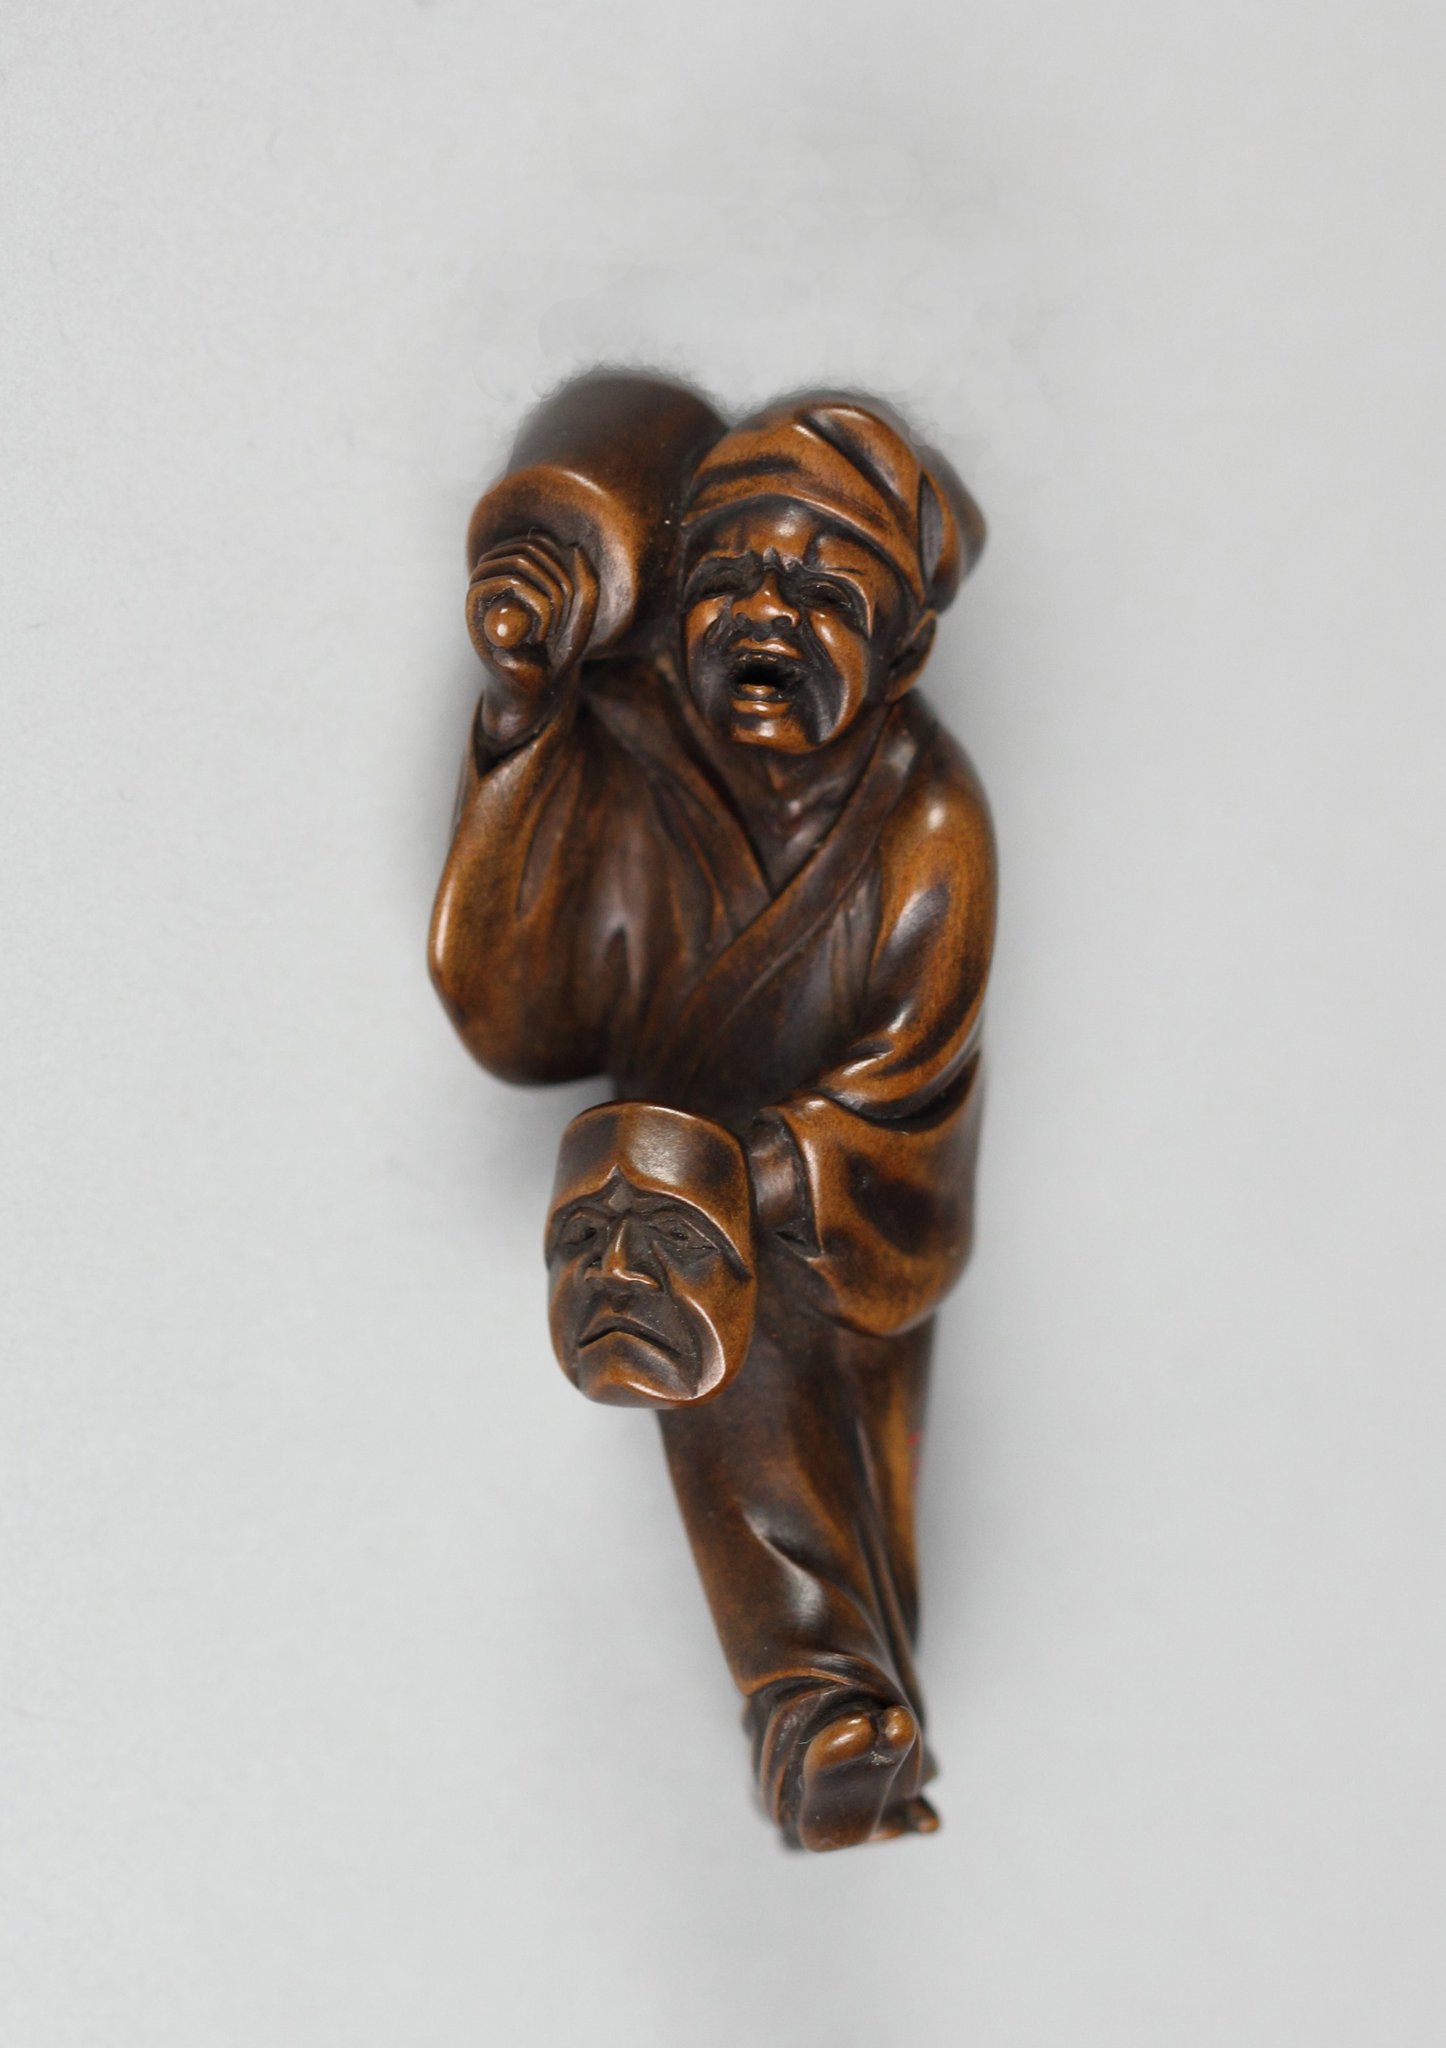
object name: netsuke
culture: japanese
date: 1701-1800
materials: wood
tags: masks,men